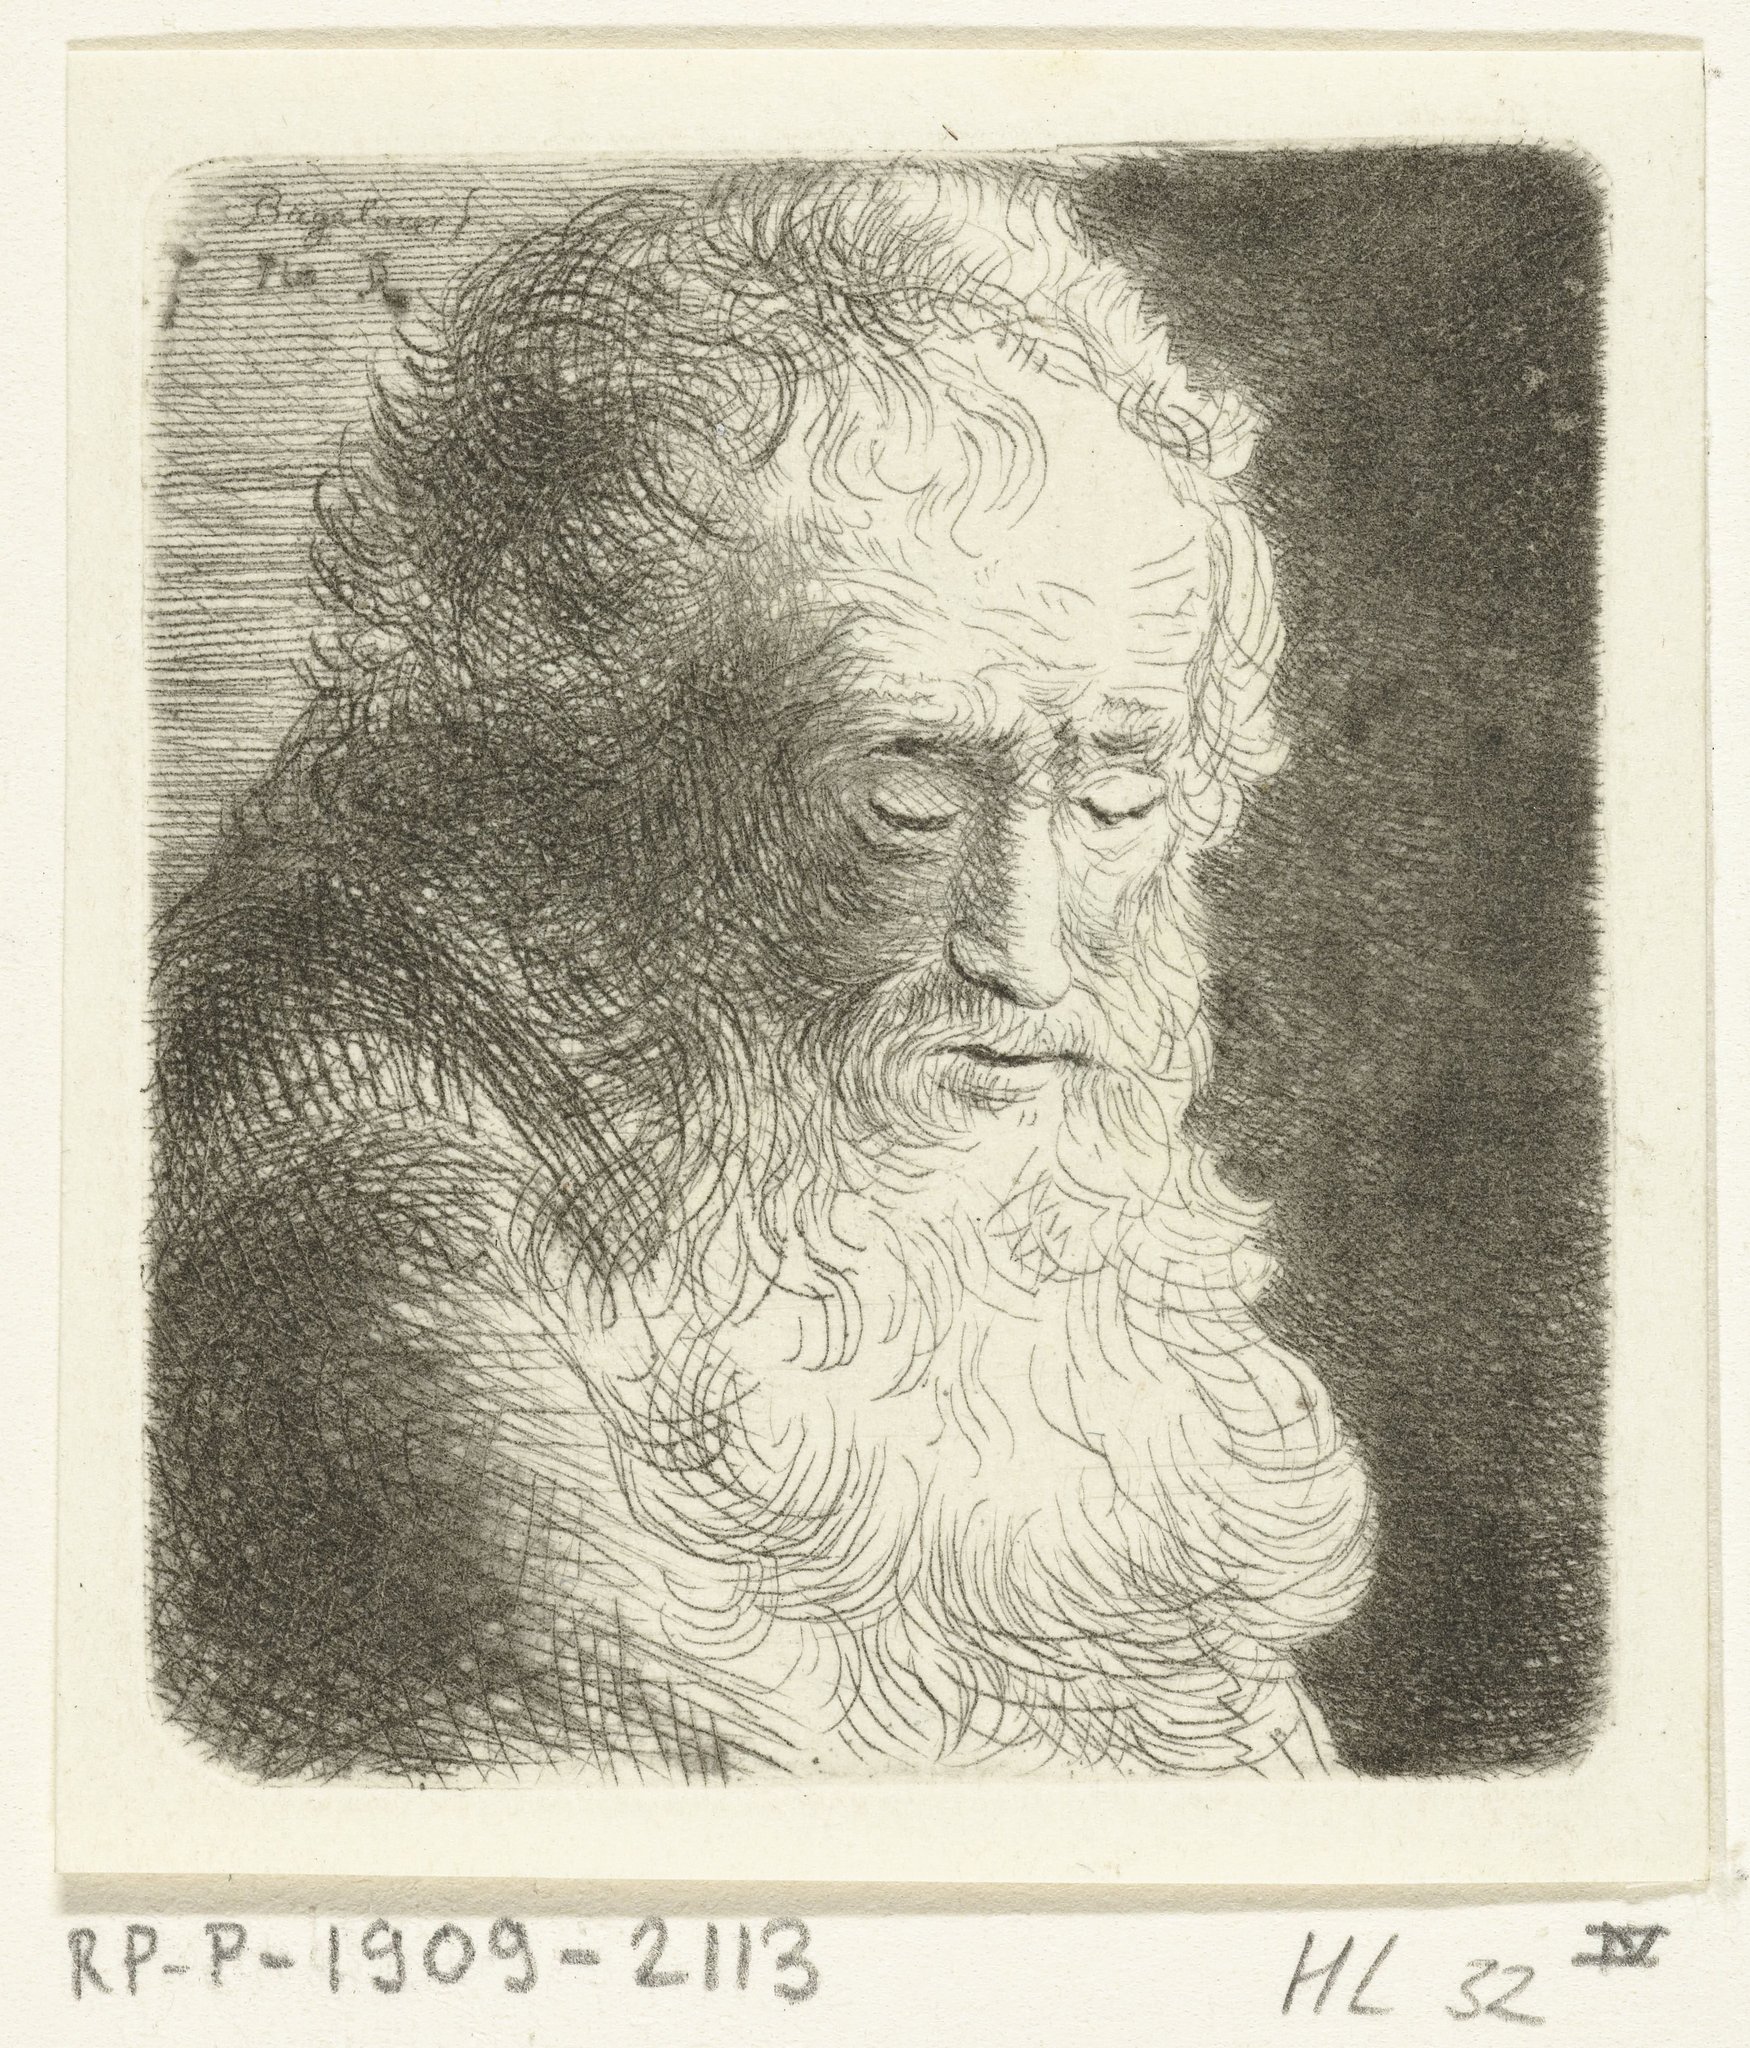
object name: print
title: Oude man met baard met de blik naar beneden gericht: driekwart, naar rechts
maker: ernst willem jan bagelaar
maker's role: draughtsman, print maker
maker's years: 1775-1837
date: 1798-1837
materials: paper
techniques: drypoint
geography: netherlands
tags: old man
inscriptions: collector's mark: Lugt 2228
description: Coll. de la Faille. kopie naar Rembrandt: Bartsch 260